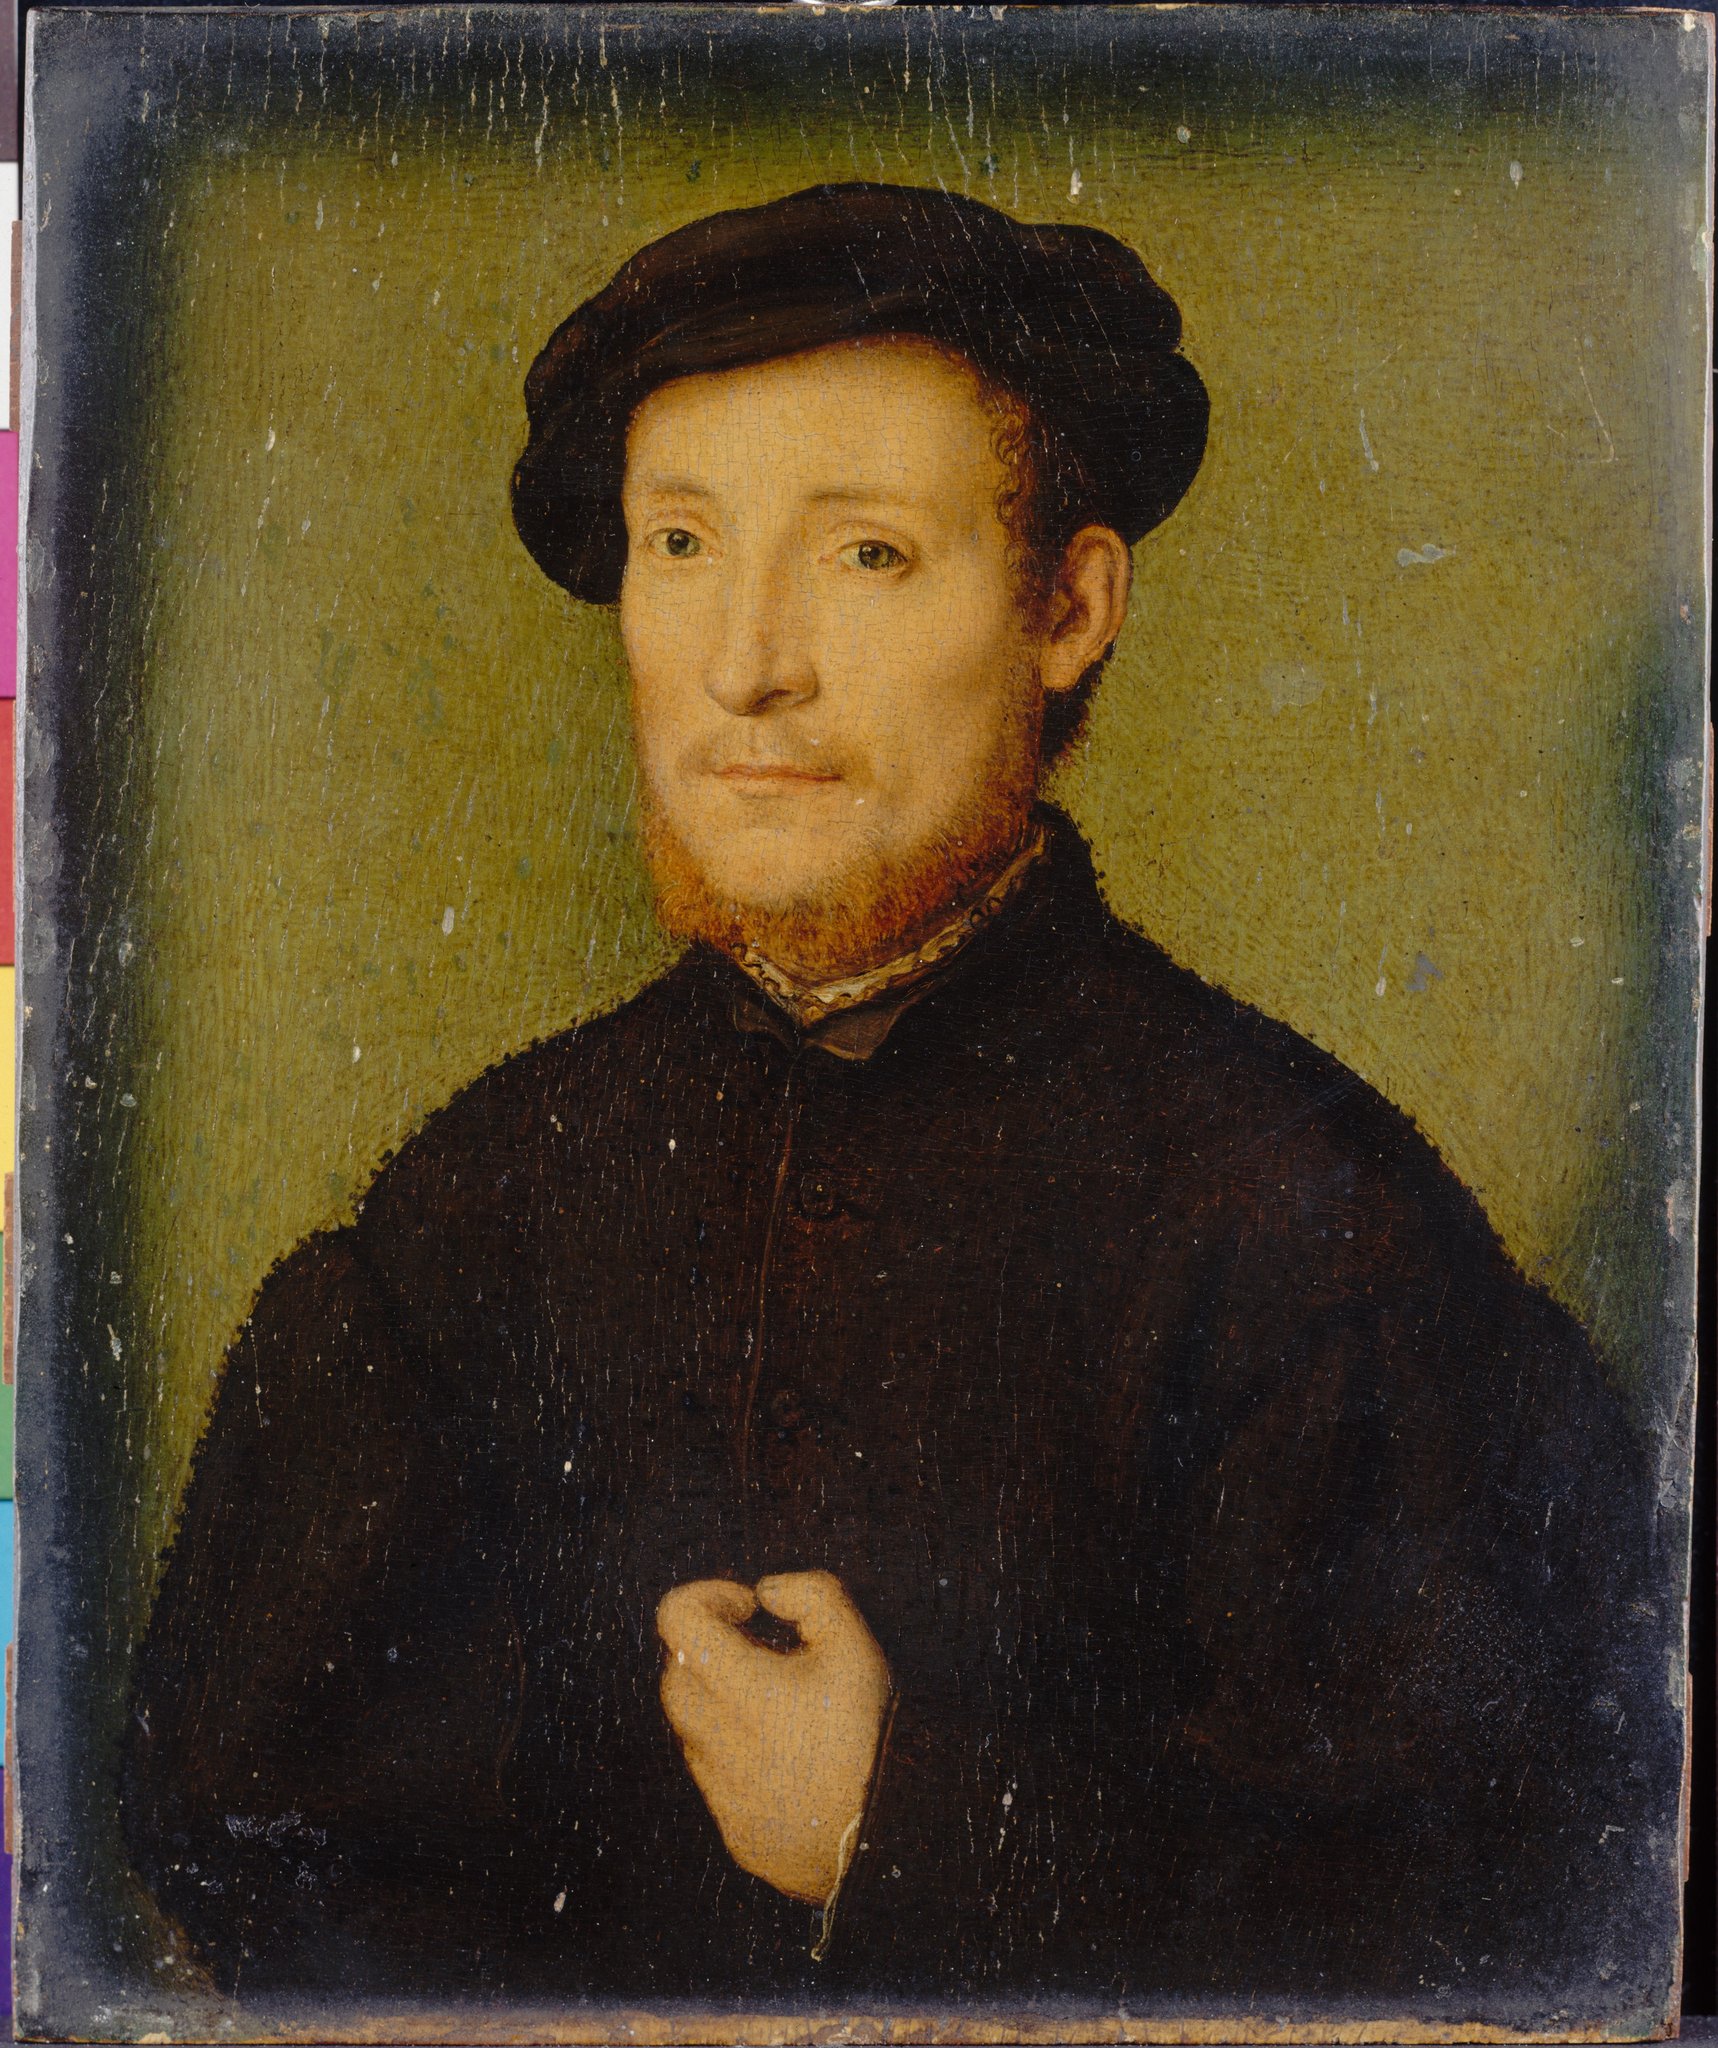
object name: painting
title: Portrait of a Man with His Hand on His Chest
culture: dutch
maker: attributed to corneille de lyon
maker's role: artist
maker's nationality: netherlandish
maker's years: 1533-1575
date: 1540-1545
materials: oil, wood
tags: men,portraits